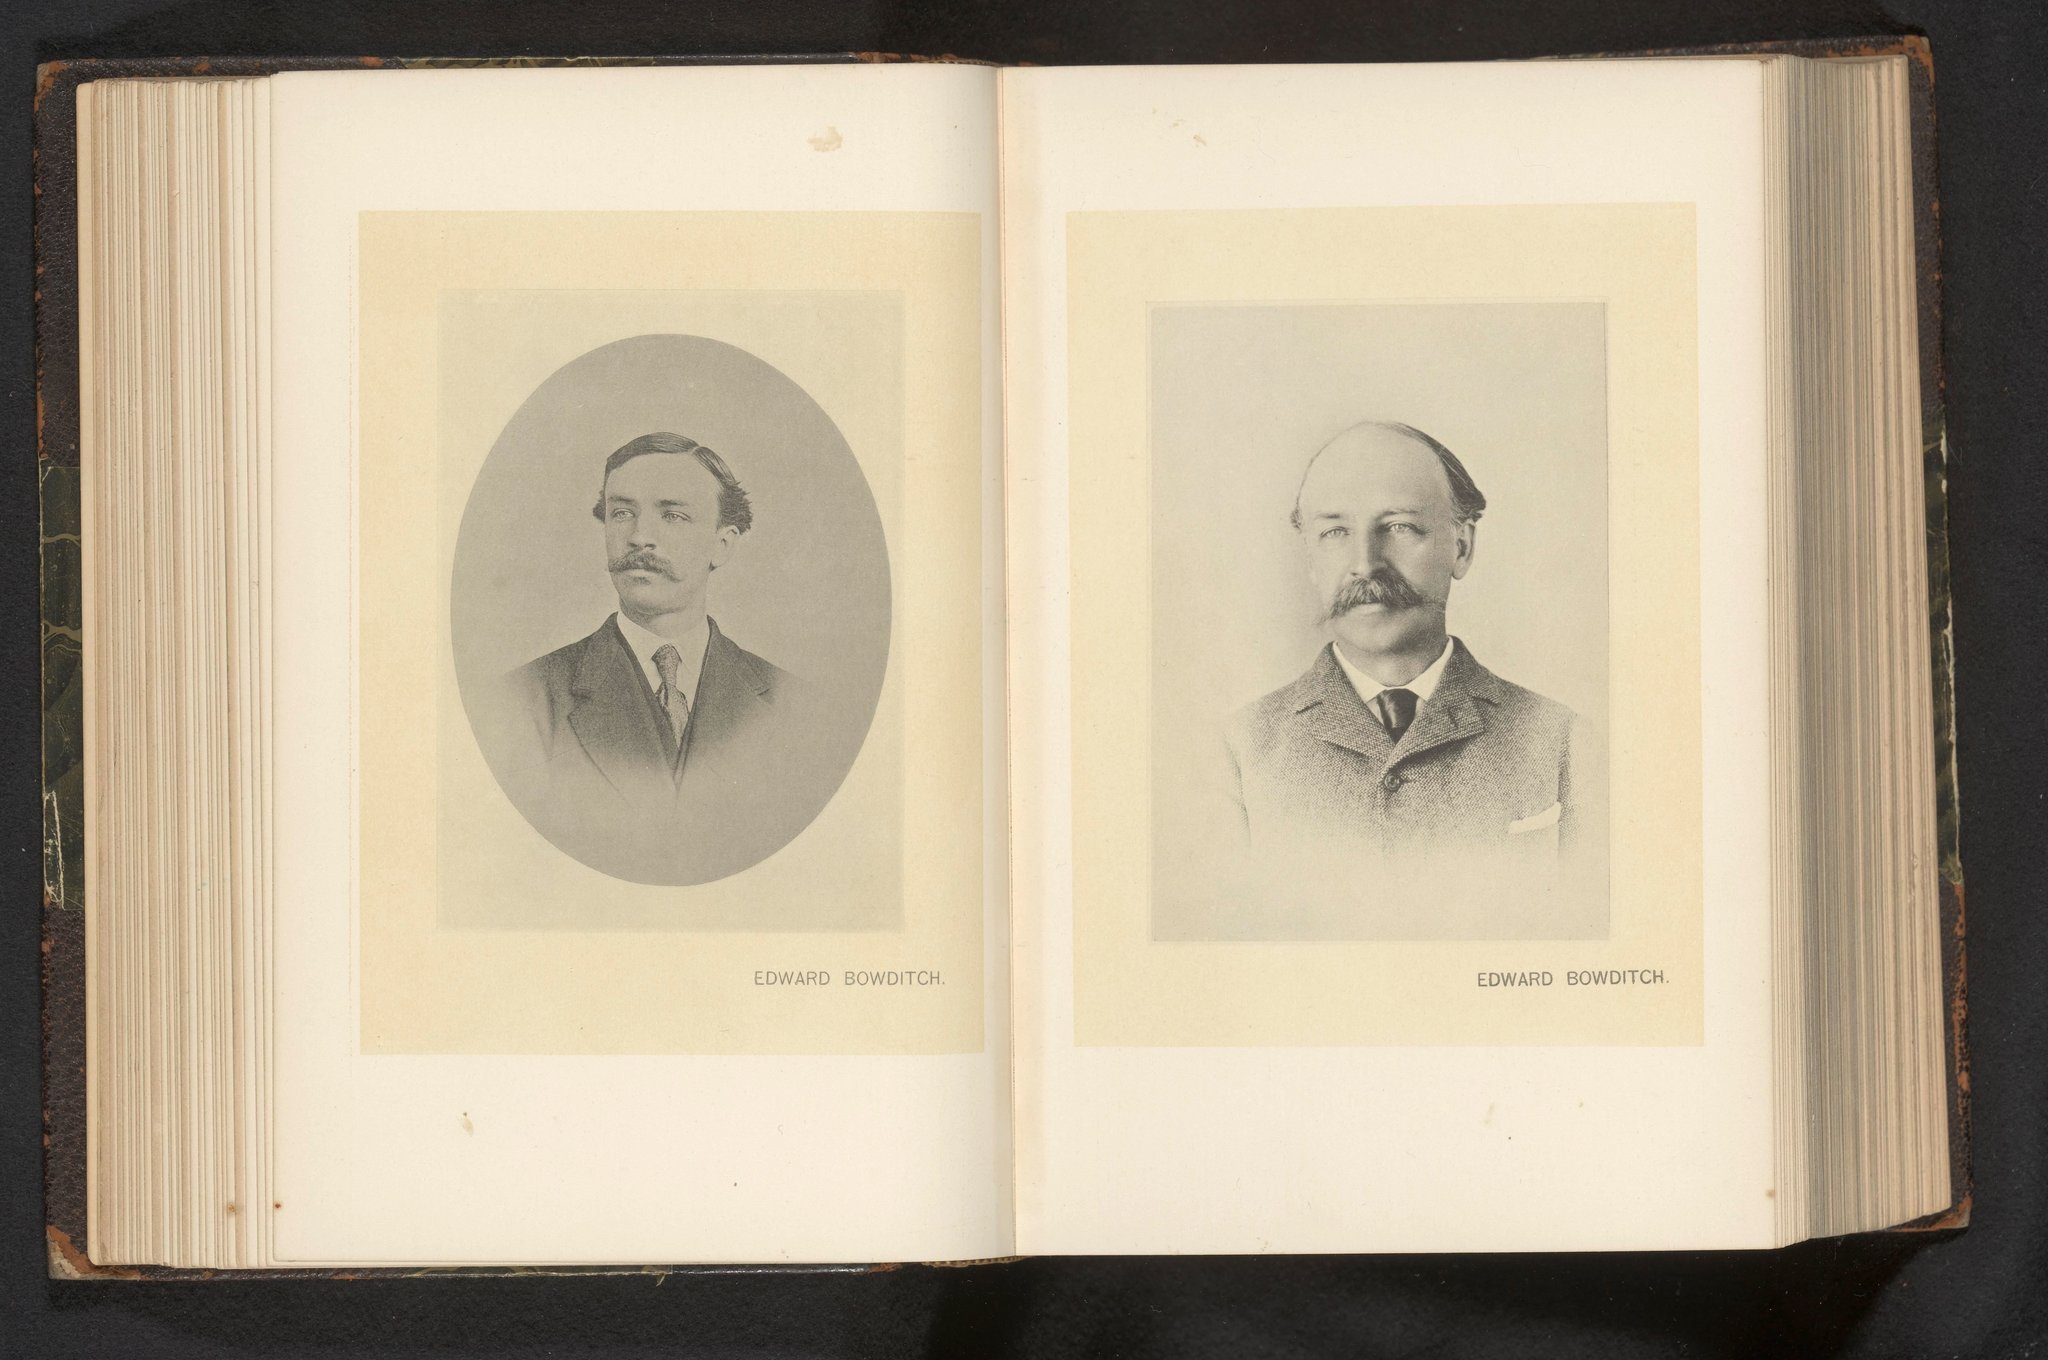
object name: photomechanical print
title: Edward Bowditch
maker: Anonymous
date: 1869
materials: paper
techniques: photoaquatint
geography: boston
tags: adult man